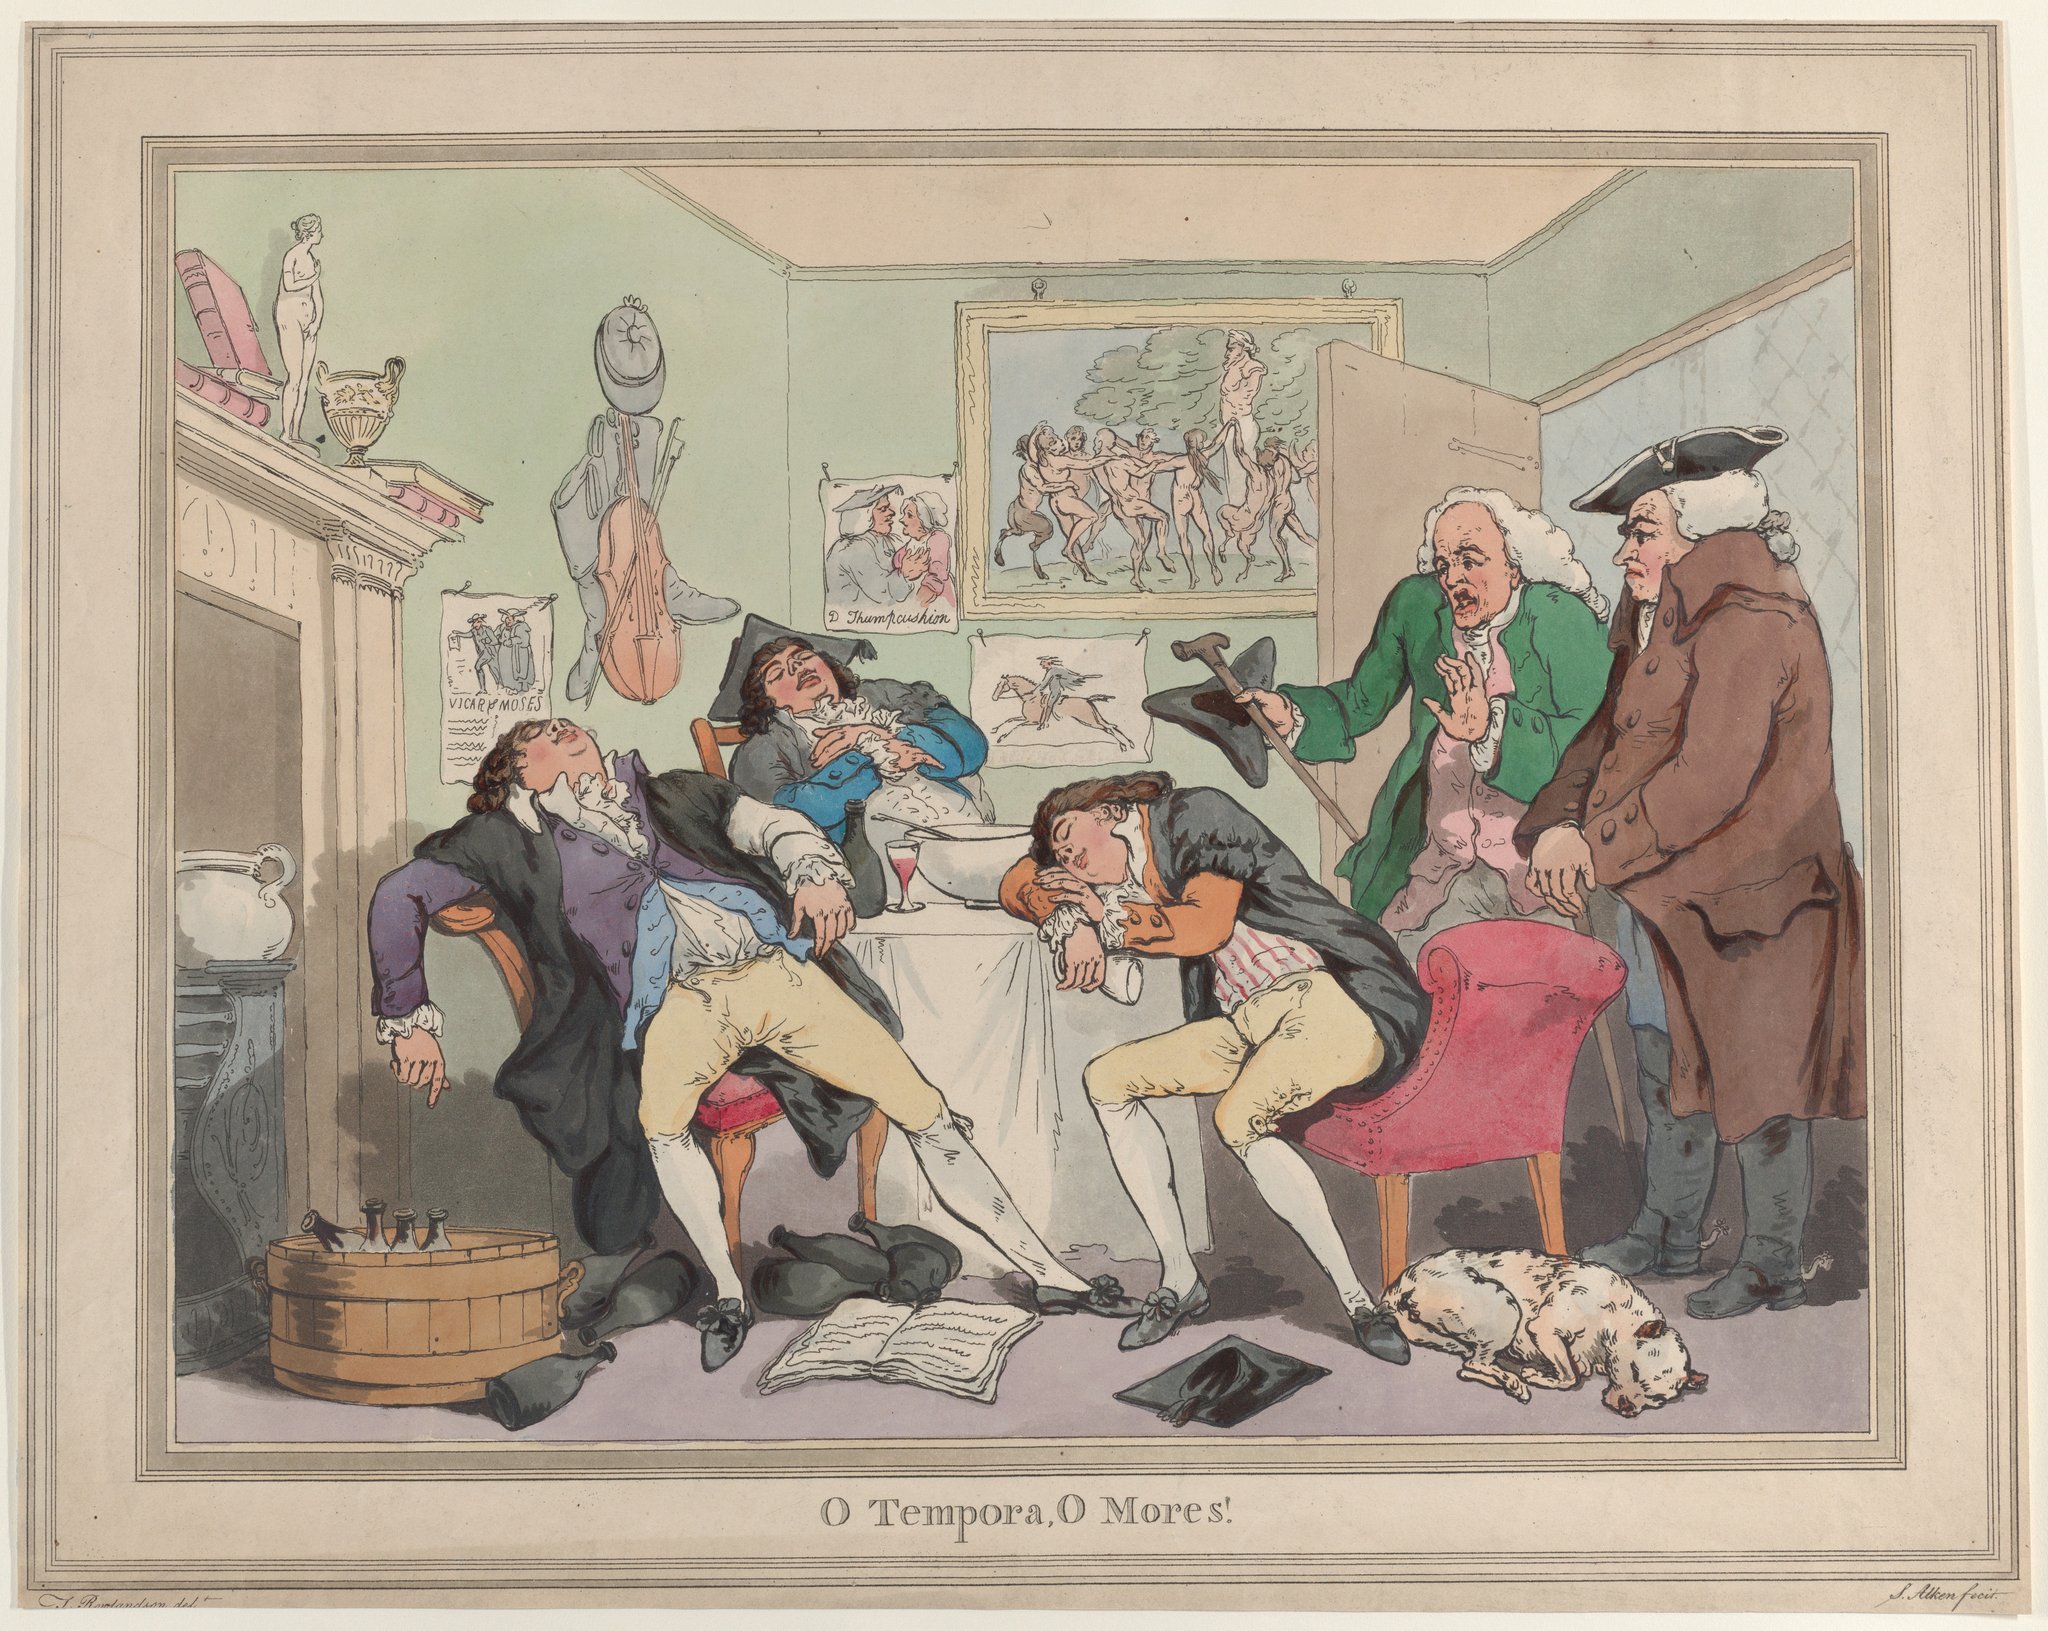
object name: print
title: O Tempora, O Mores!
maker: samuel alken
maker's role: etcher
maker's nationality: british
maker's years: 1756-1815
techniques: etching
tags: satire,sleeping,men,dogs